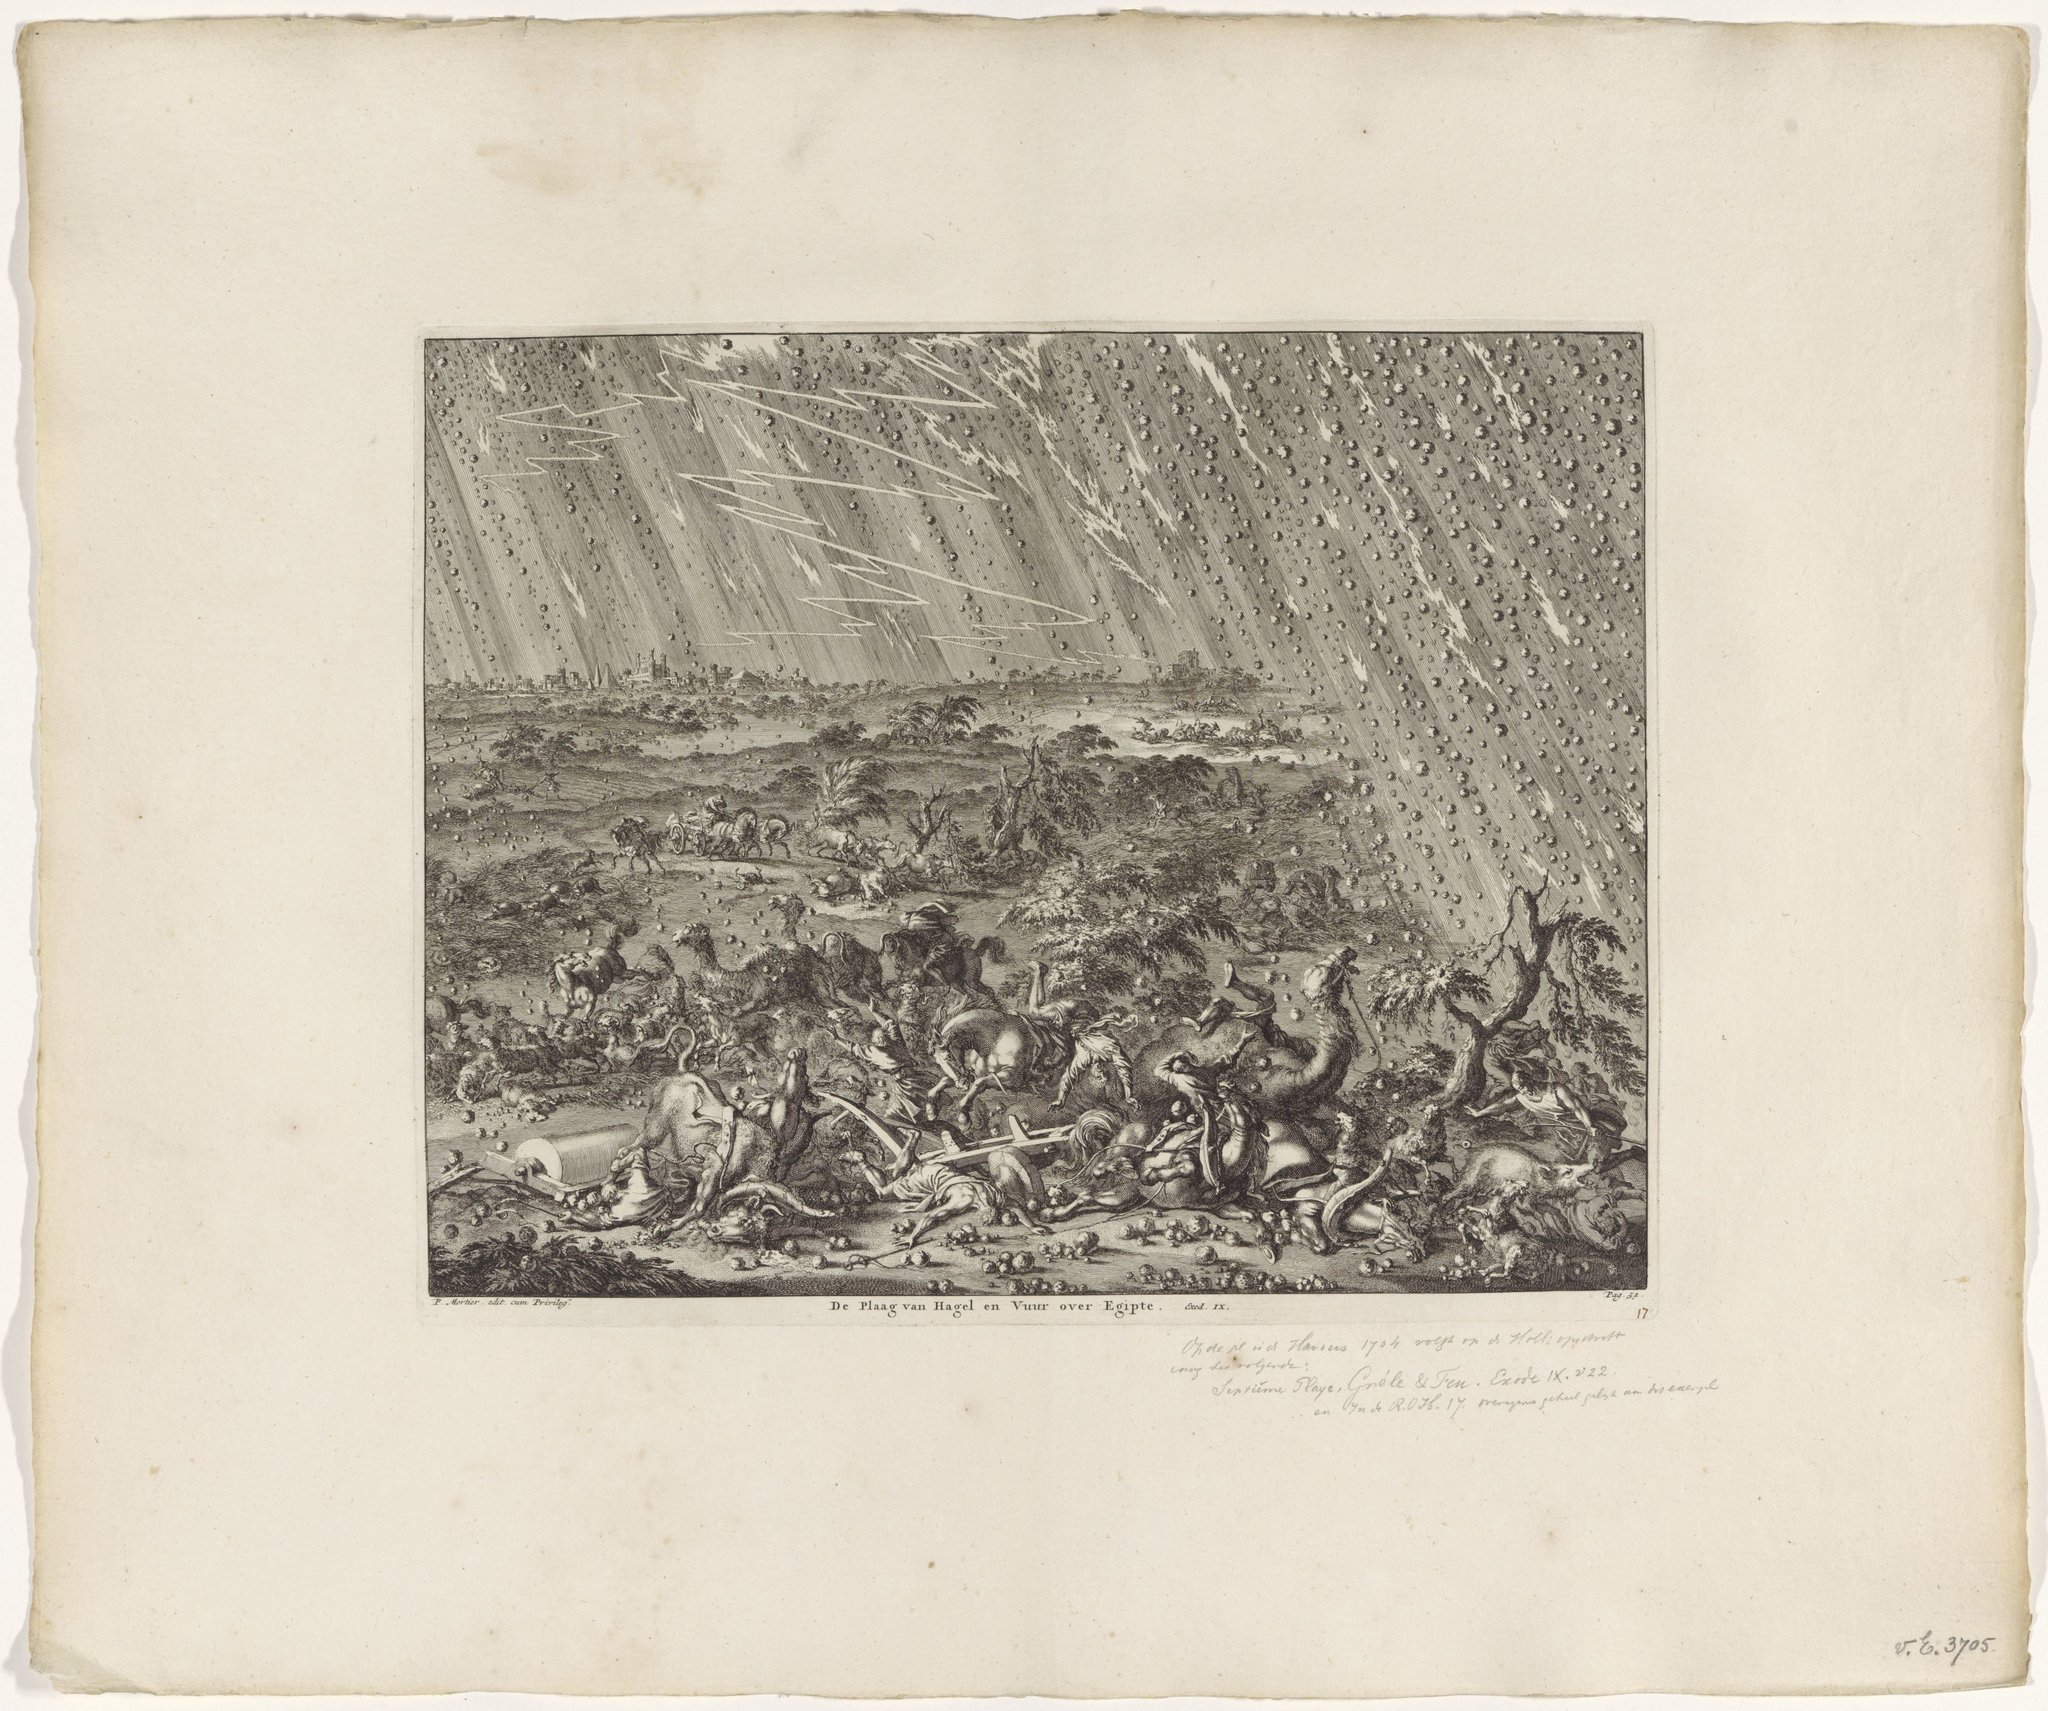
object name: book illustration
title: Plaag van hagel en onweer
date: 1708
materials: paper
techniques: etching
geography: amsterdam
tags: the plague of hail: moses raises his rod towards the sky, and hail and fire fall to the ground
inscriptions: collector's mark: Lugt 2228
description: Gezicht op een landschap waar het onweert, bliksemt en waar mensen en dieren worden getroffen door enorme hagelstenen. Op de achtergrond de contouren van een stad. De prent is een verbeelding van de zevende plaag die God over Egypte liet komen.